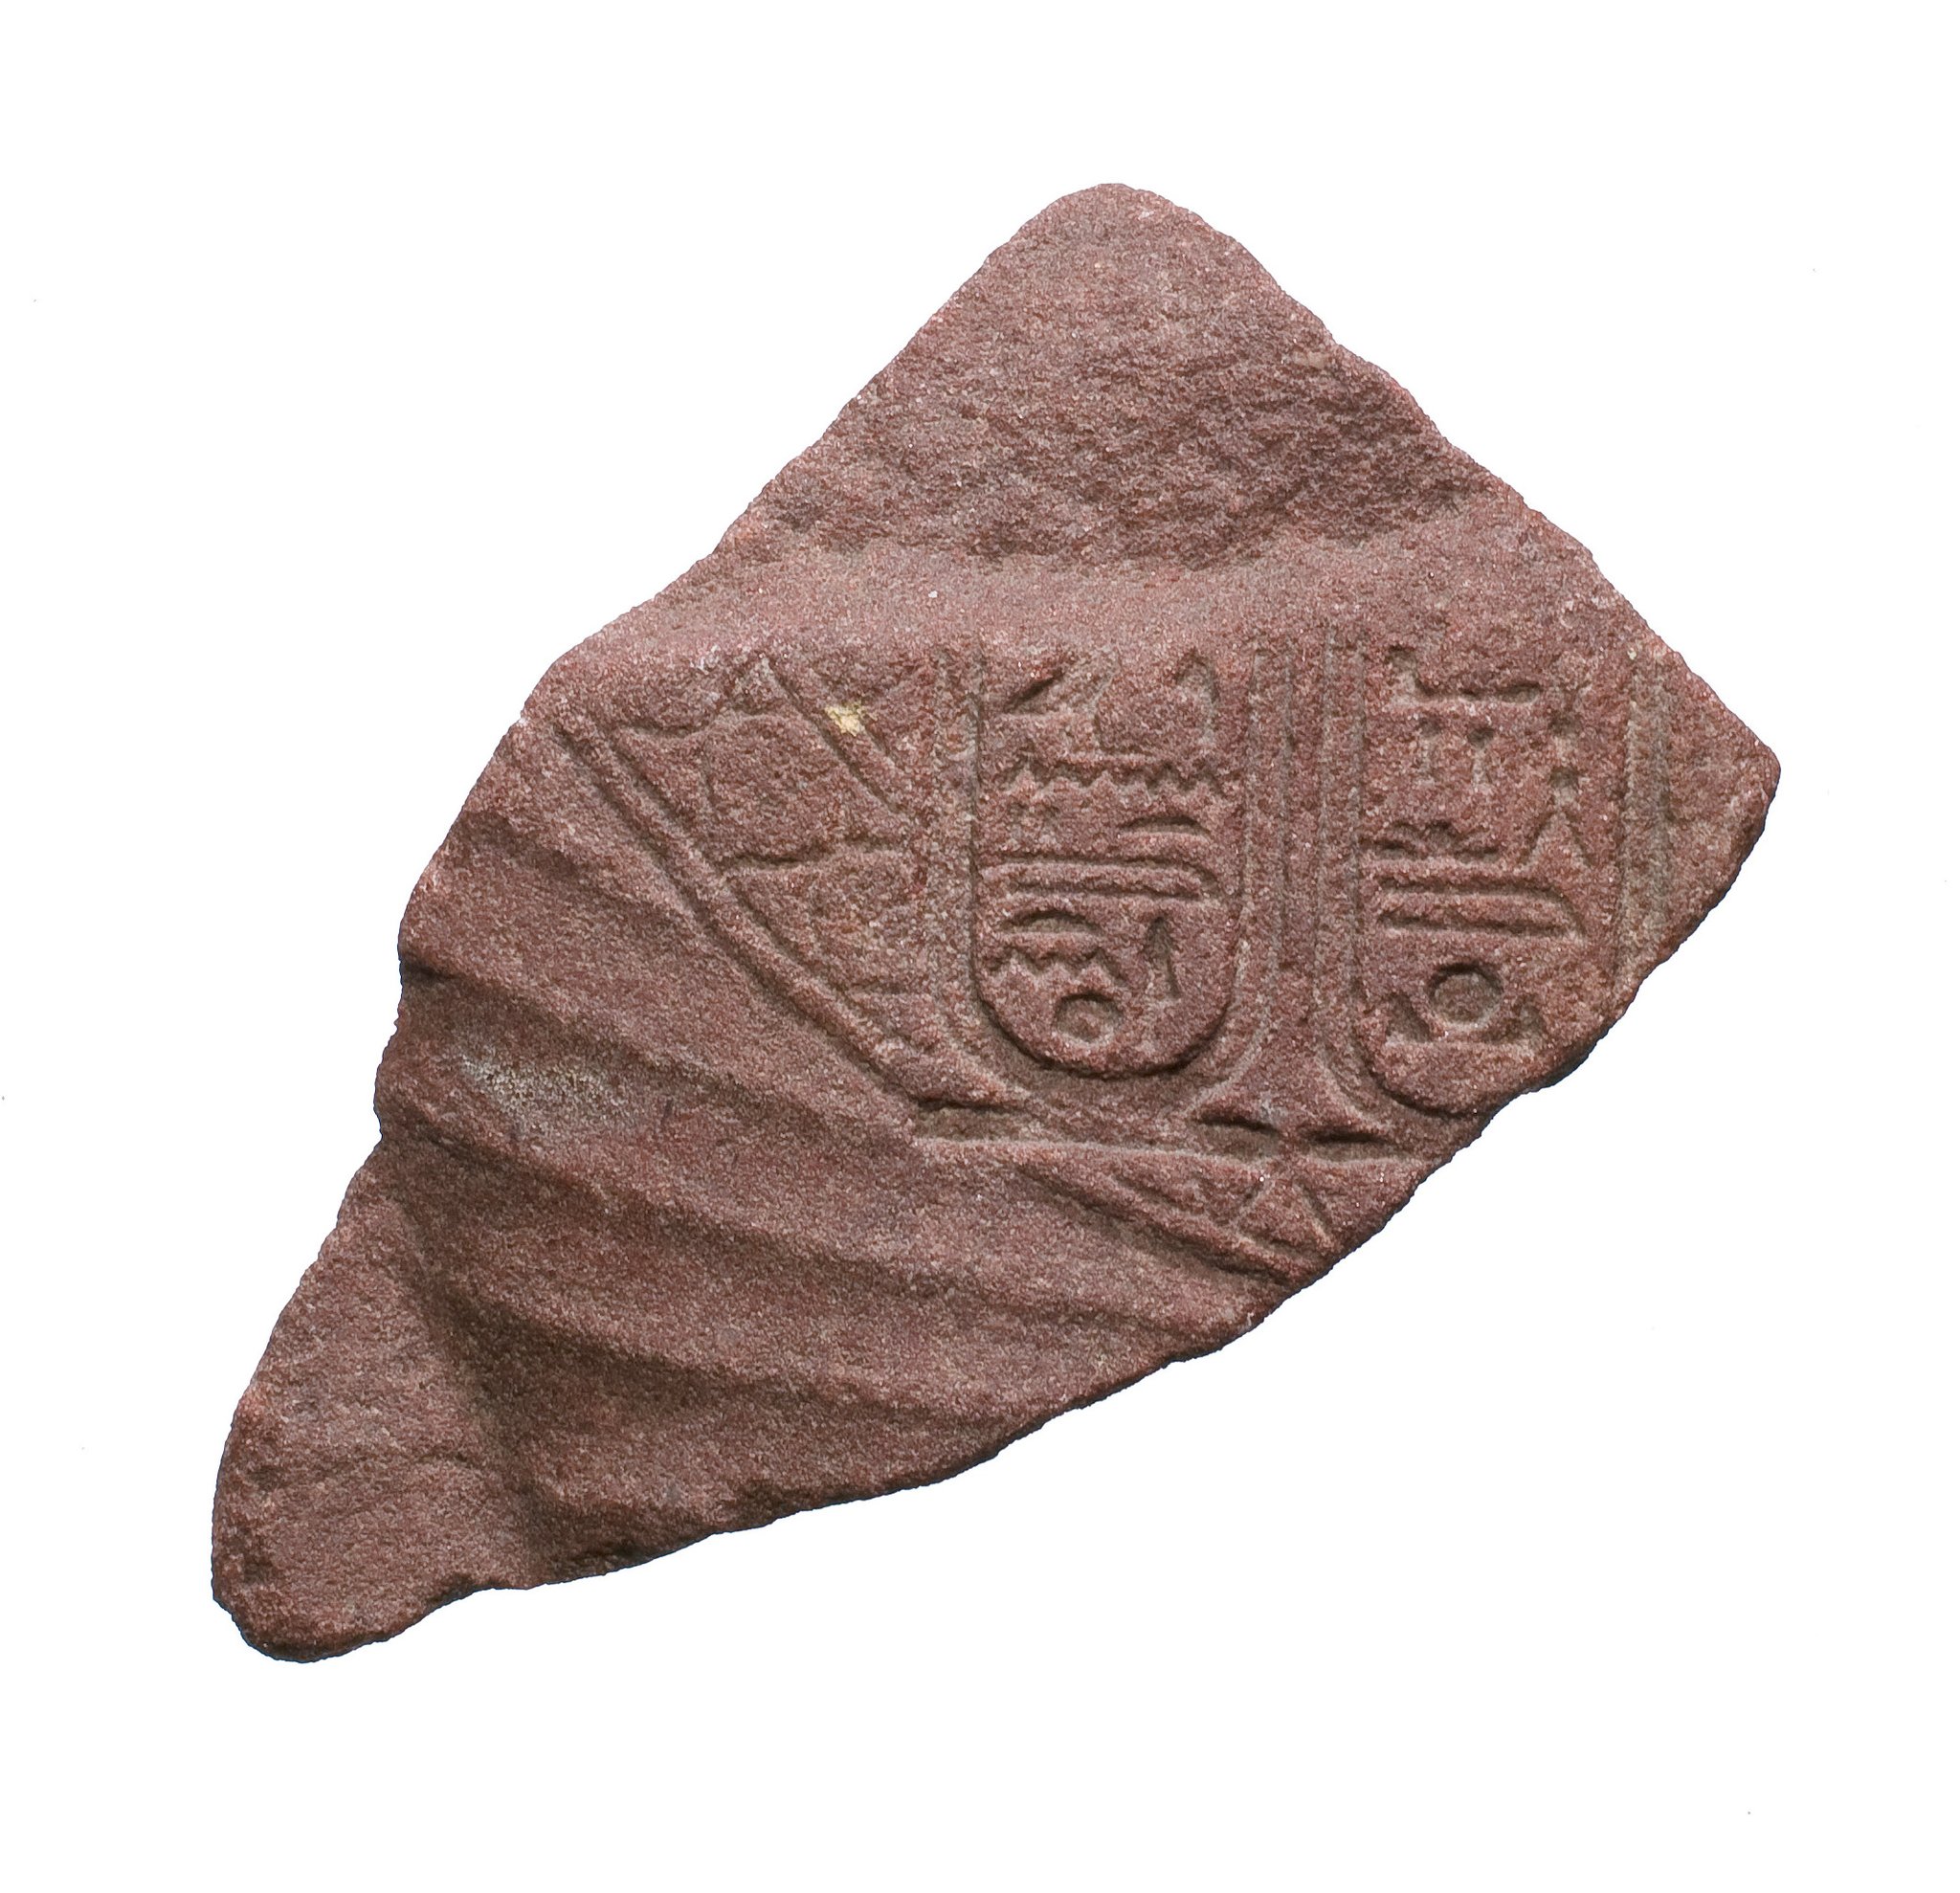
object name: right chest of queen, collar, aten cartouch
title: Upper right chest of queen in pleated garment and elaborate broad collar, with cartouches of the Aten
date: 1353-1336 BCE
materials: quartzite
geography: egypt